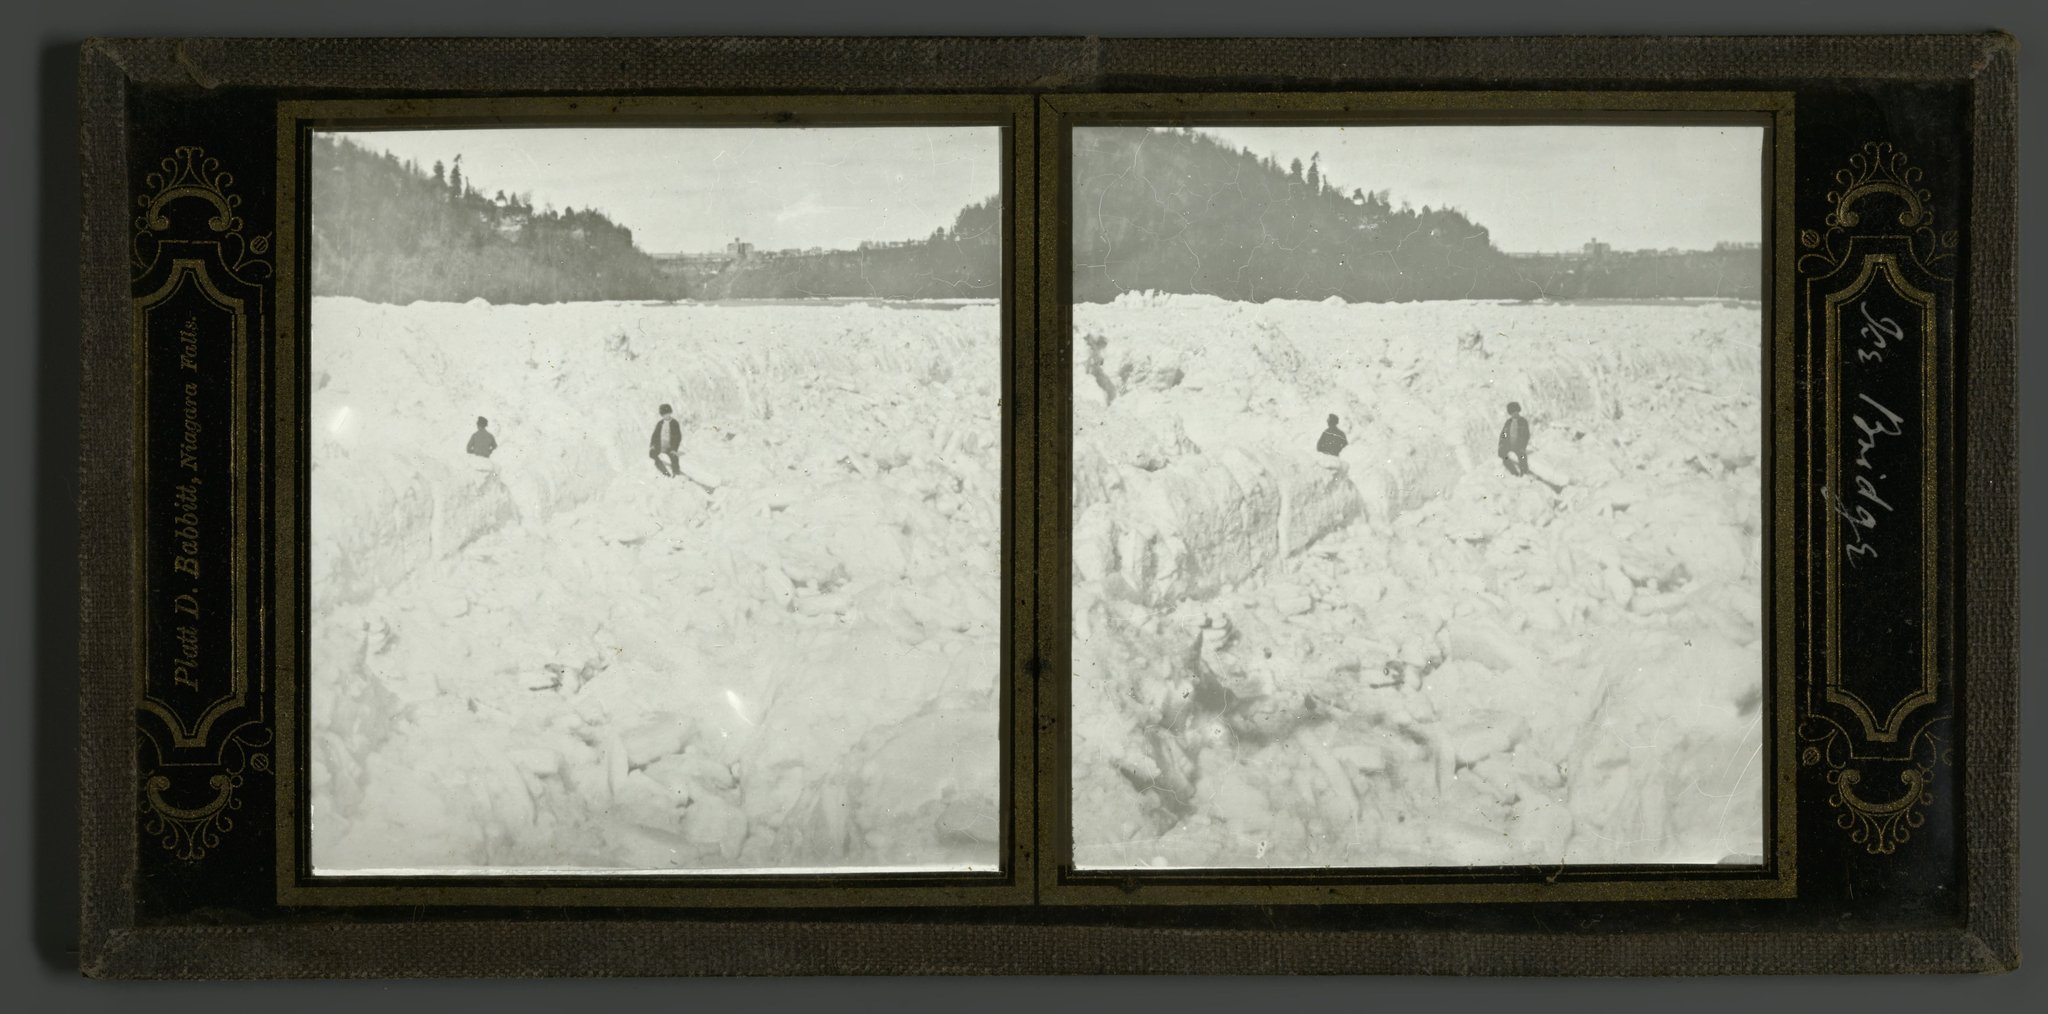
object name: stereoscopic photograph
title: Twee figuren op de bevroren bedding van de Niagarawatervallen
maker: platt d. babbitt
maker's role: fotograaf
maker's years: 1822-1879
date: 1860-1879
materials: glass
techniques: slide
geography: niagara falls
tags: dry river, river bed (+ landscape with figures, staffage), drift ice